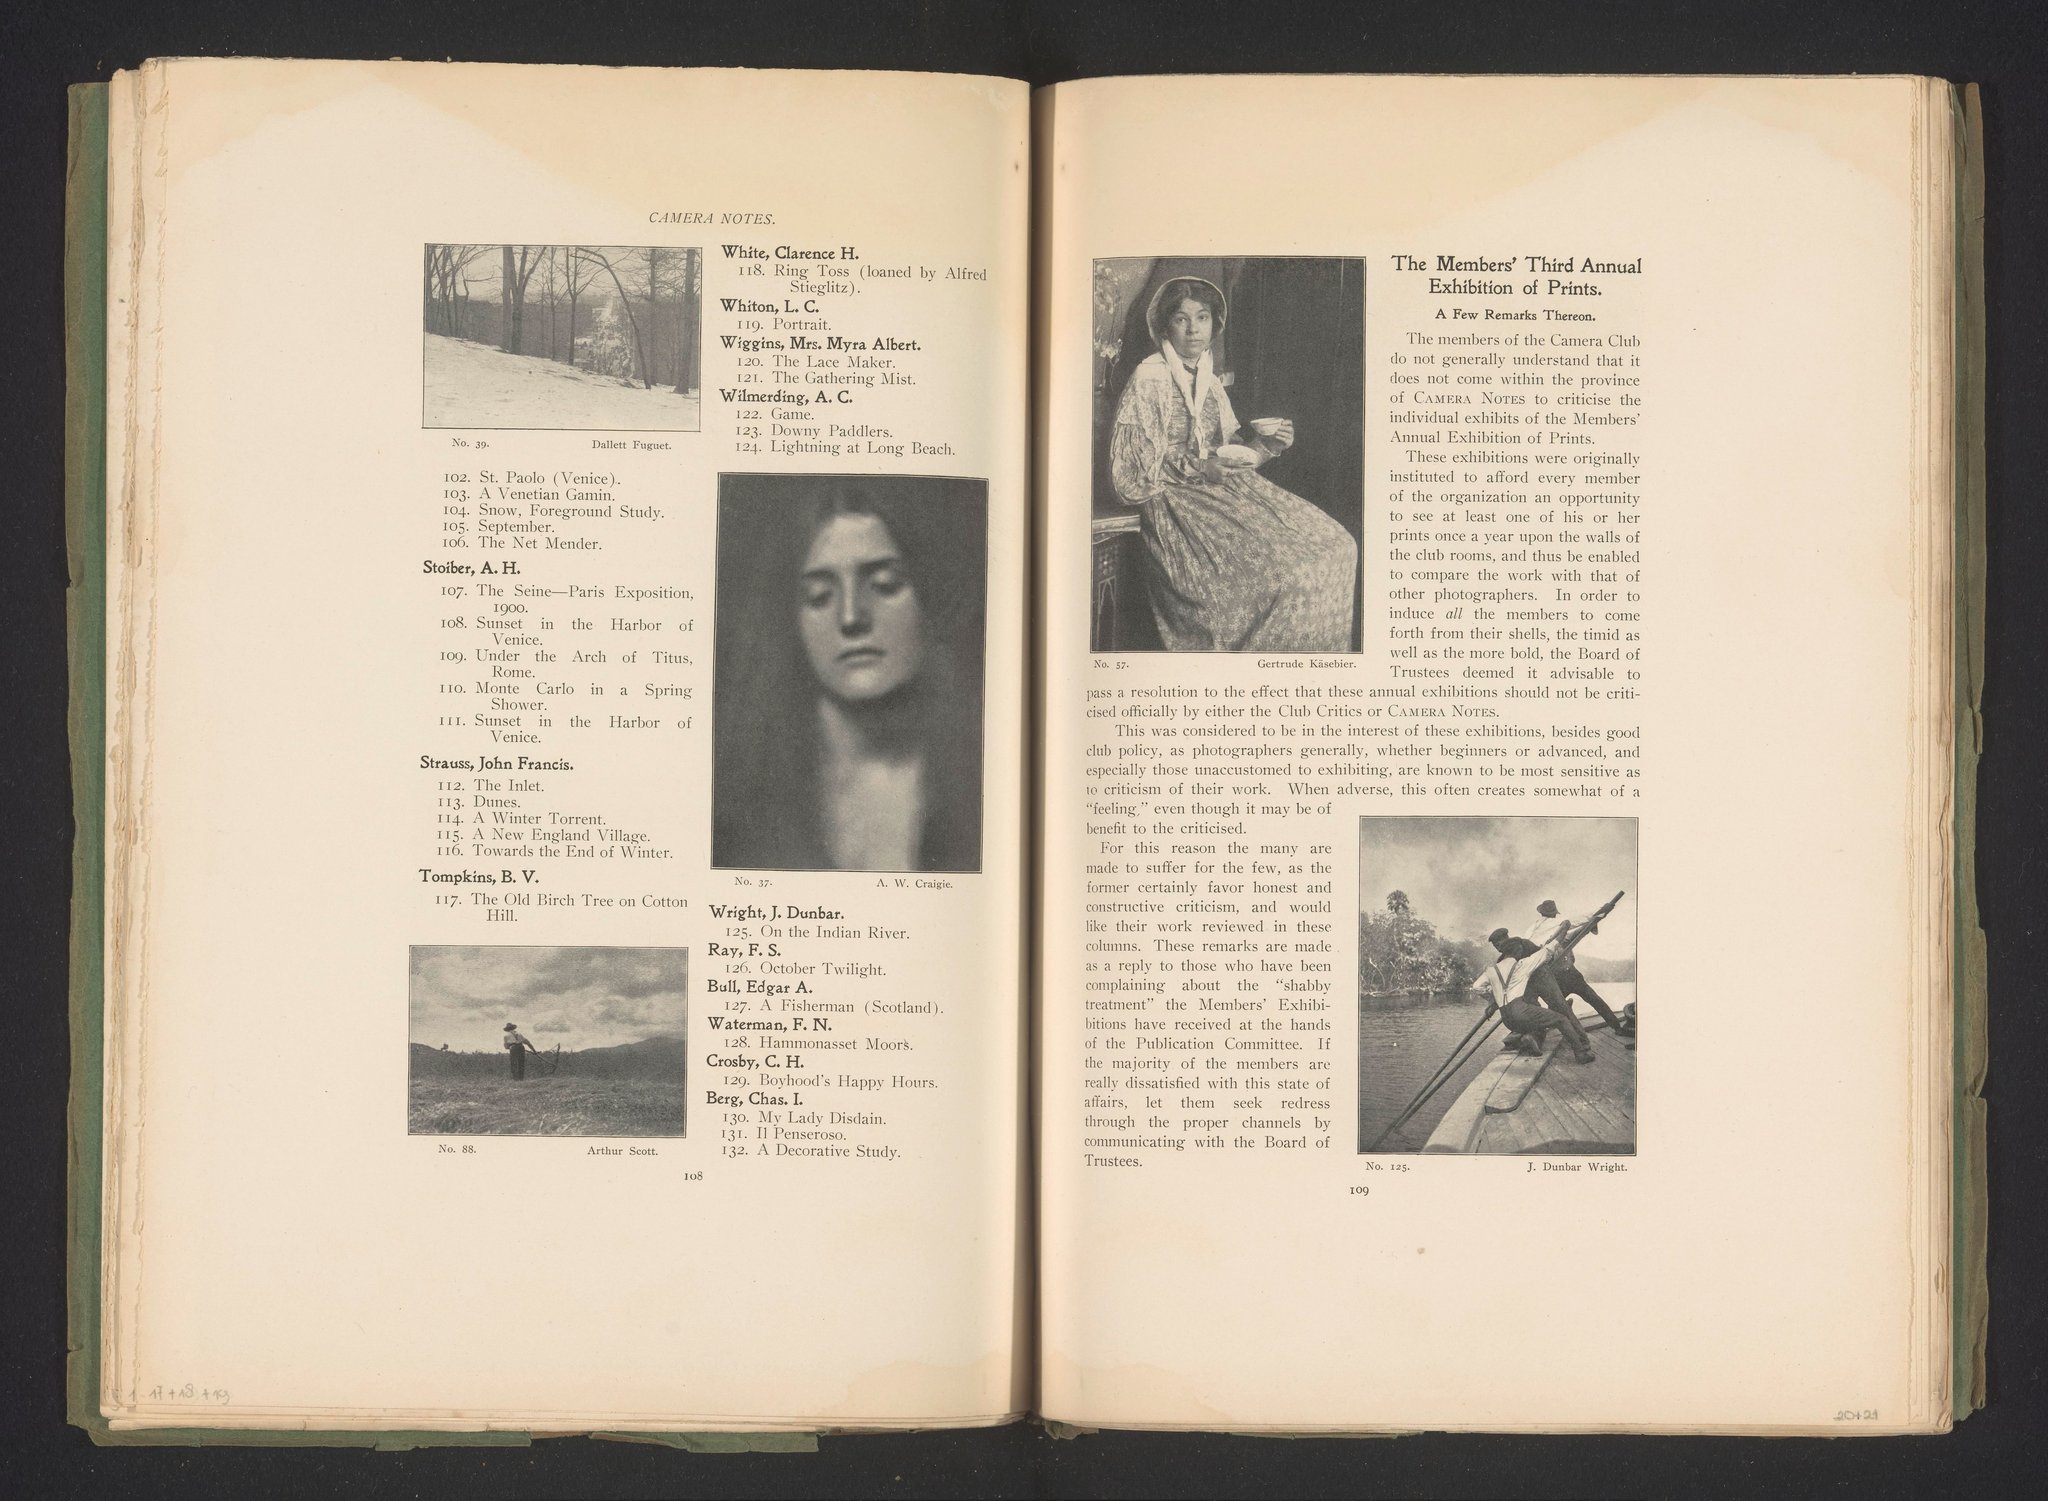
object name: page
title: Drie mannen duwen een schip af met stokken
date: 1895-1900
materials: paper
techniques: autotype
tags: sailing-ship, sailing-boat, pushing something (+ three persons), adult man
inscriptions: number: ‘No. 125’